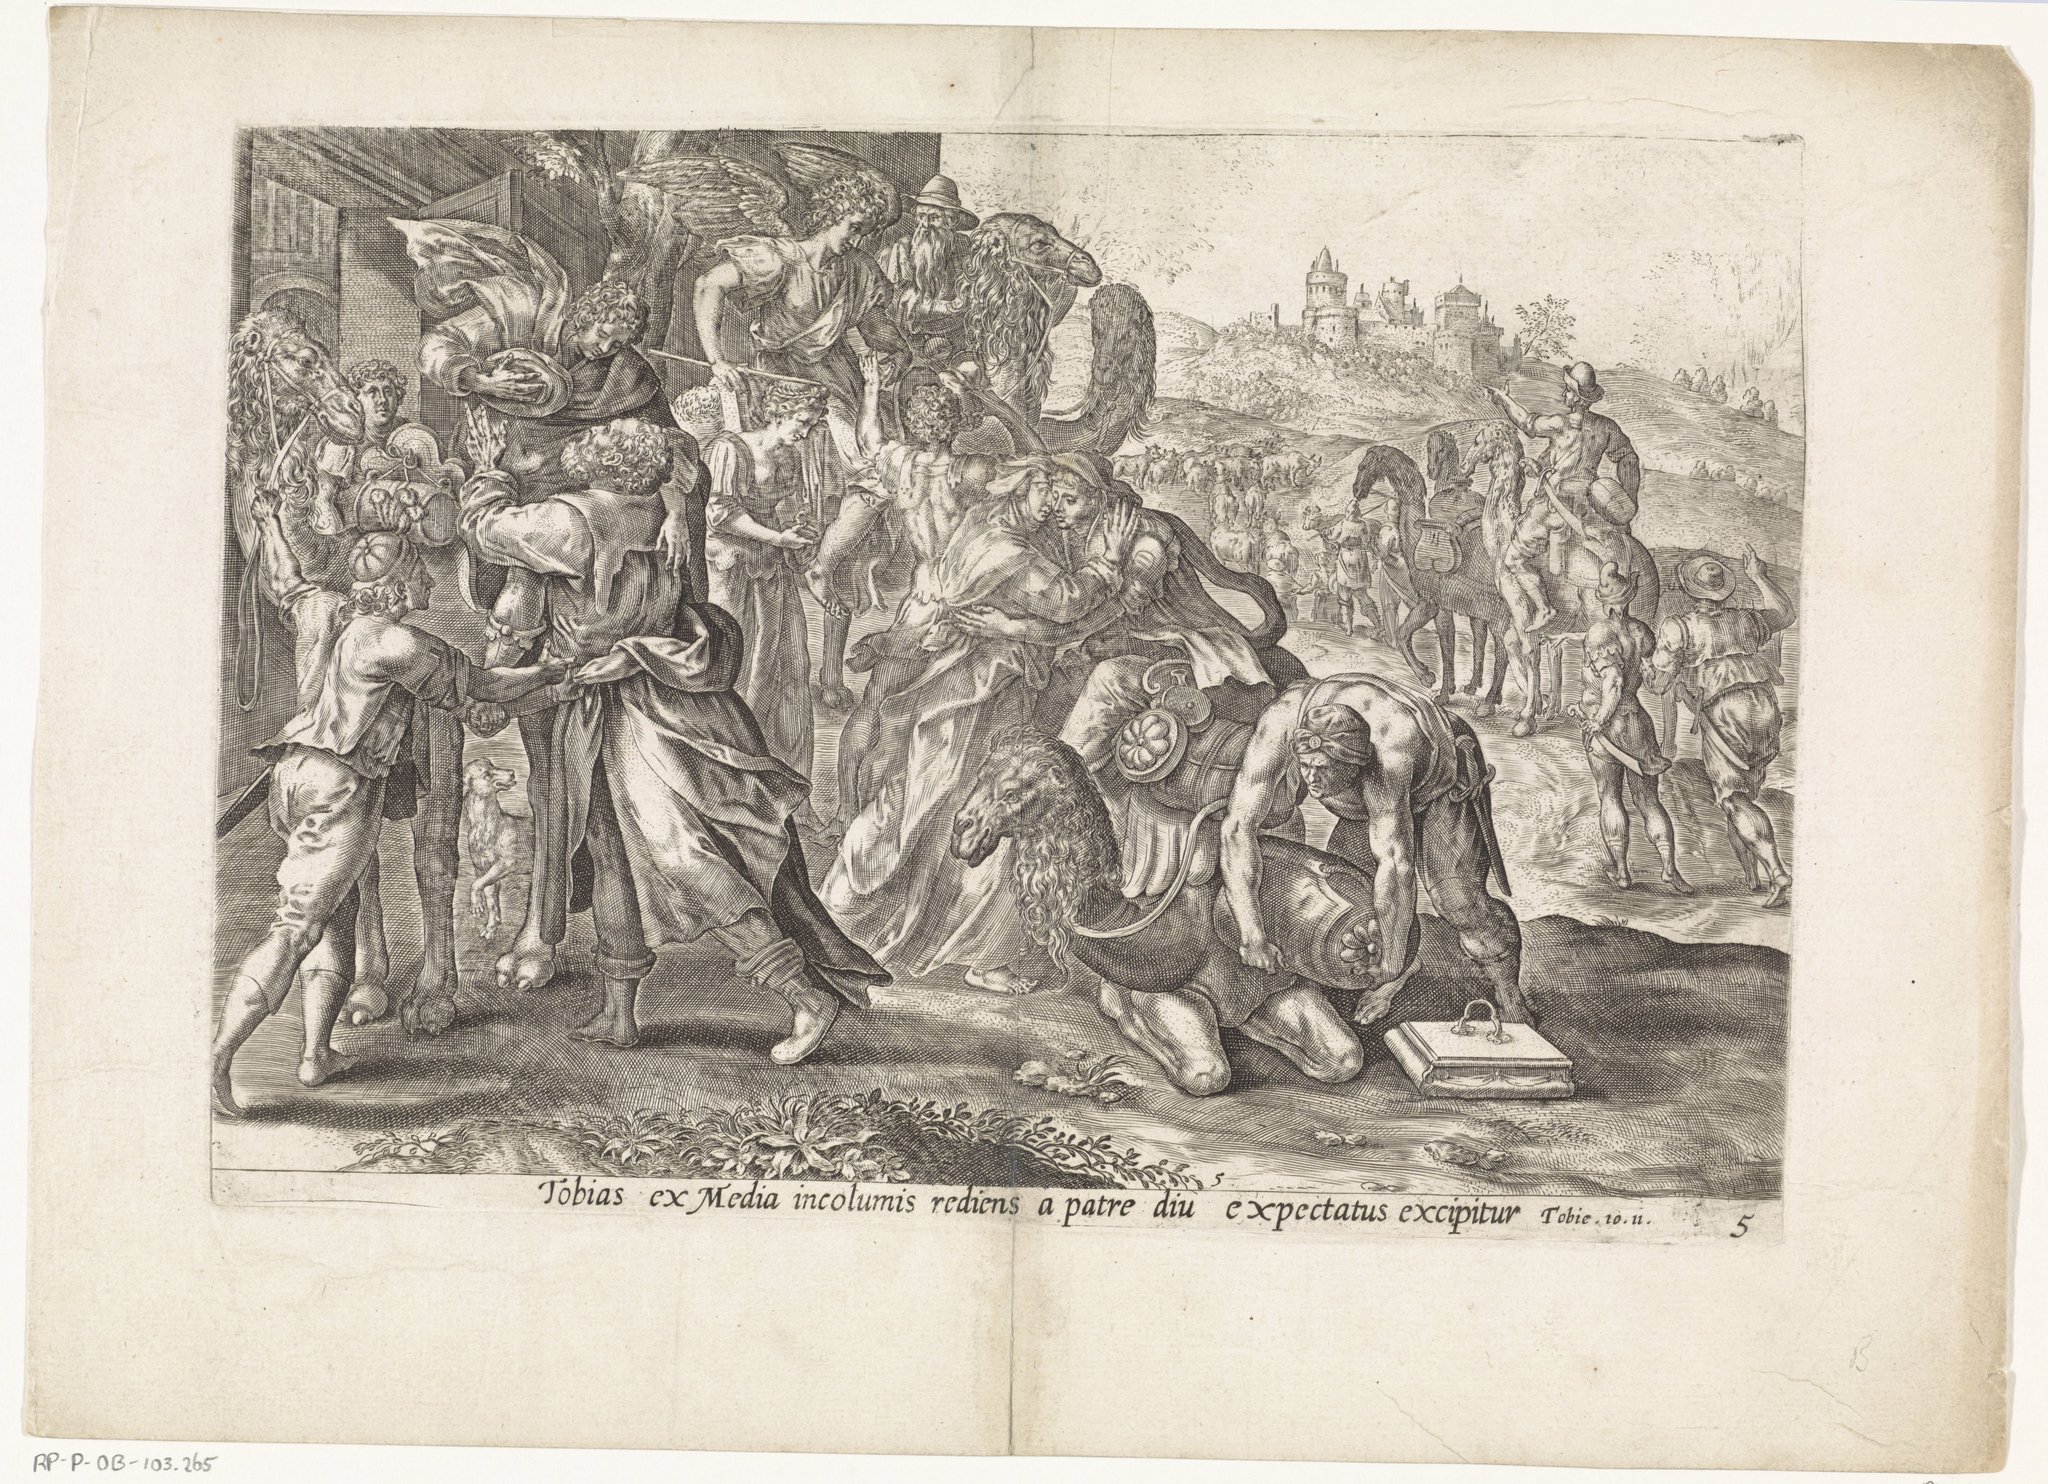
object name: print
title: Tobias, Sara en de engel nemen afscheid van Raguel en Edna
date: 1585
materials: paper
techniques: engraving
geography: amsterdam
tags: the leave-taking ~ tobias' return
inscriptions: collector's mark: Lugt 2228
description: Prent gebruikt in: Theatrum biblicum : hoc est historiae sacrae veteris et novi testamenti tabulis aeneis expressae. Opus praesentatissimorum huius ac superioris seculi pictorum atque sculptorum, summo studio conquisitum et in lucem editum. Amsterdam: Claes Jansz. Visscher, 1643.